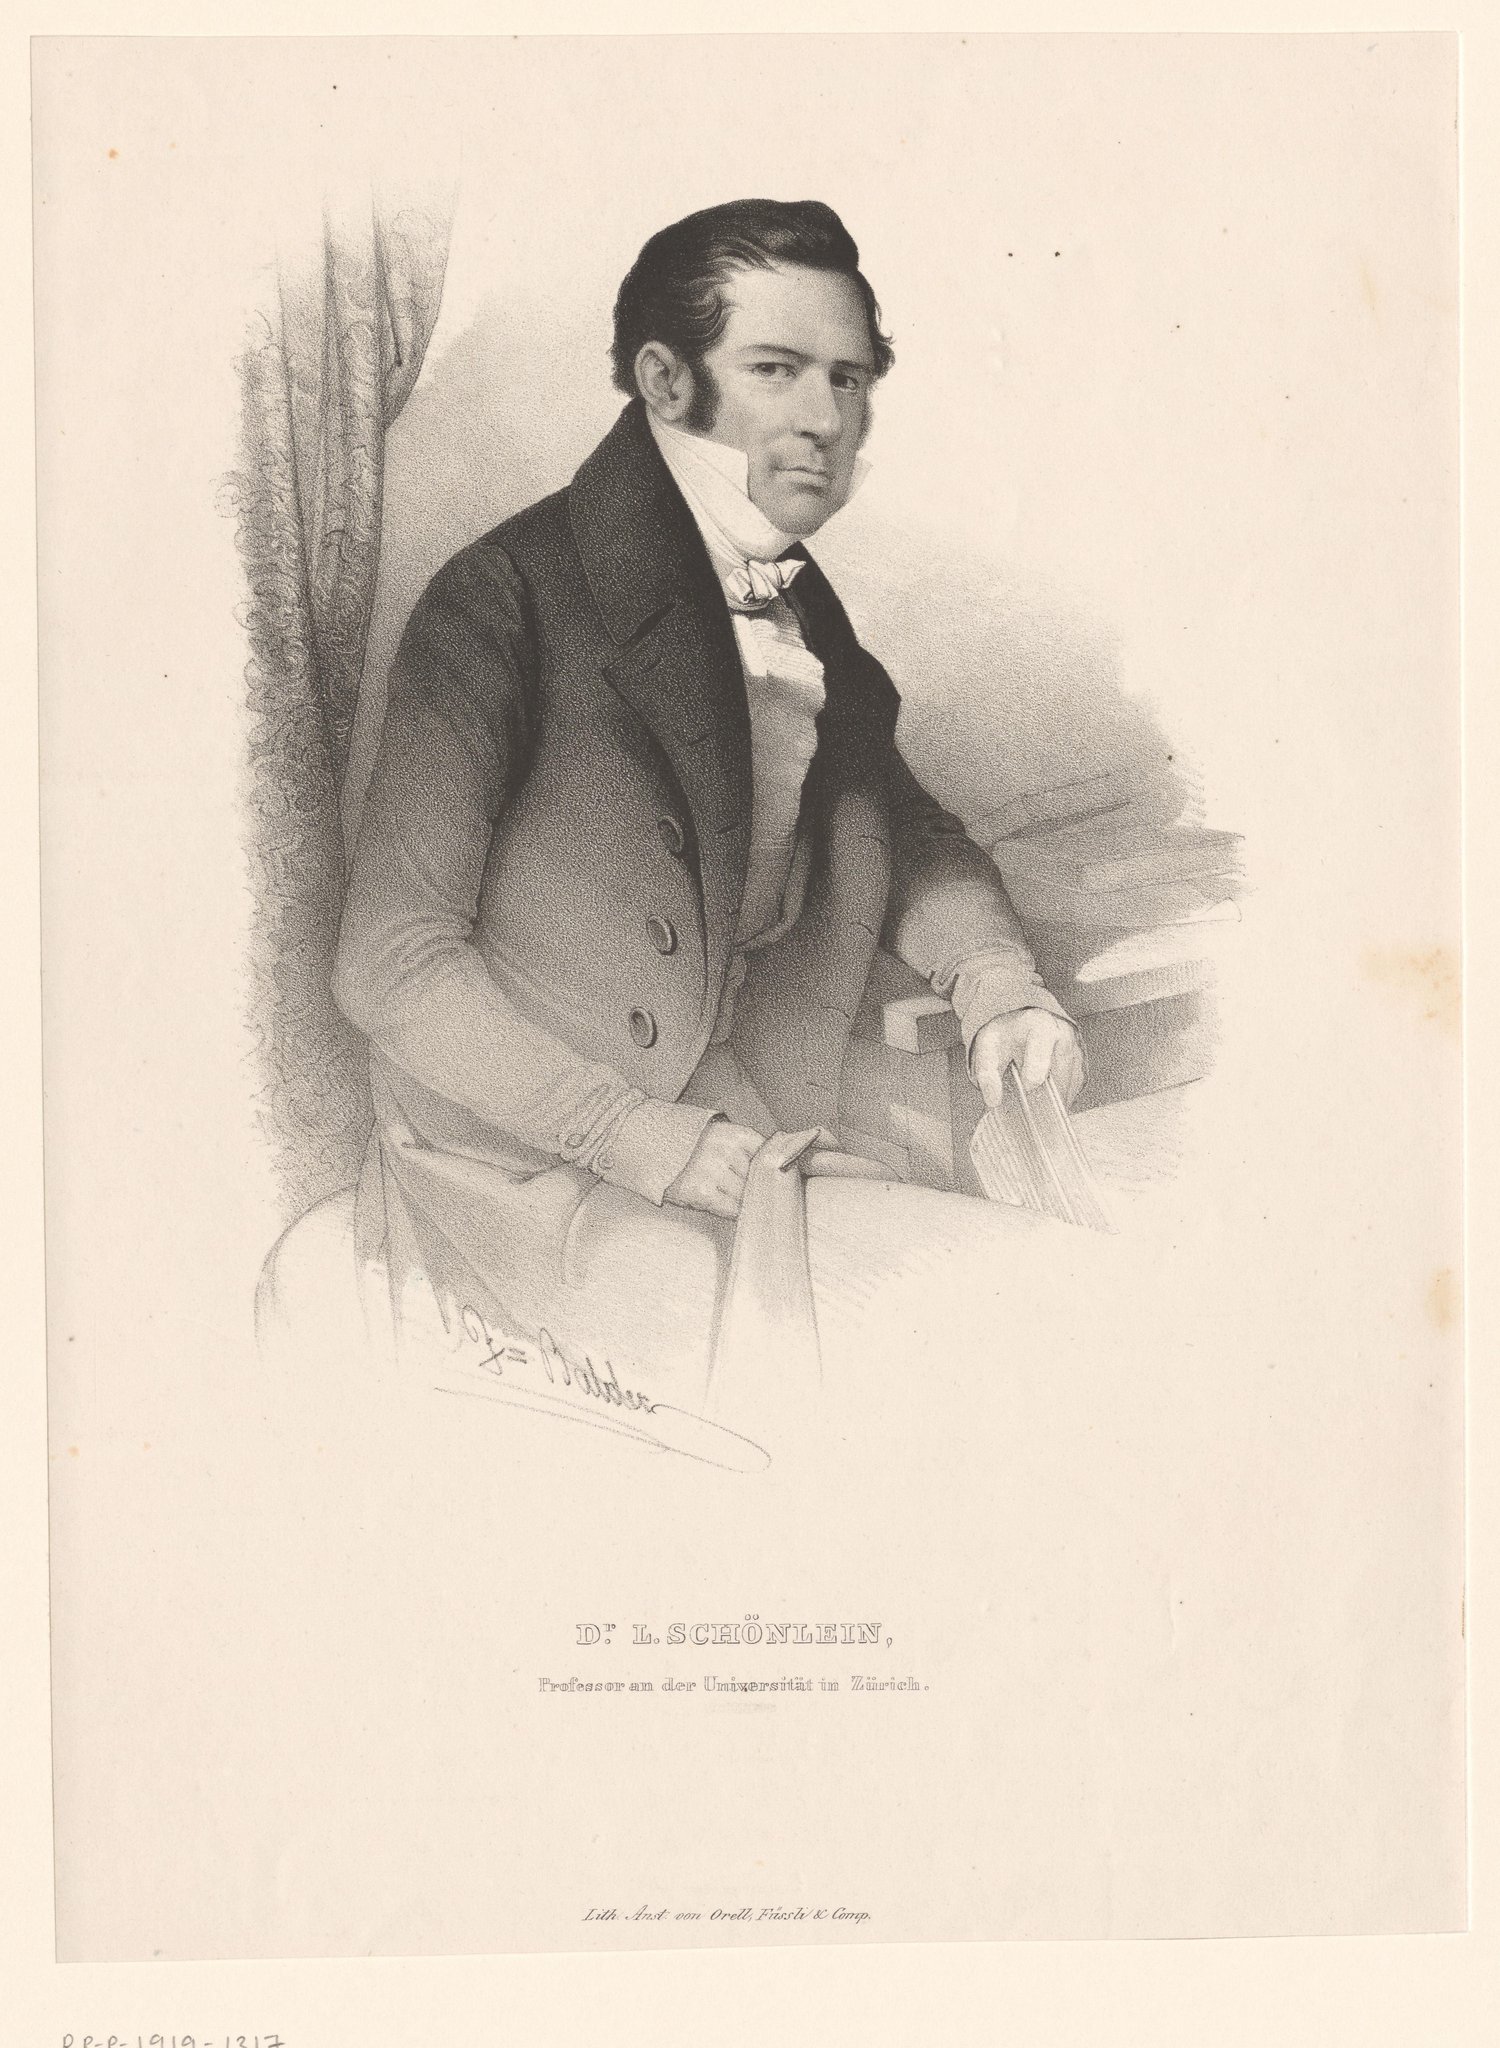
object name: print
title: Portret van Johann Lukas Schönlein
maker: georg balder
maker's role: print maker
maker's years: 1810-1882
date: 1820-1882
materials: paper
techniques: lithograph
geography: zurich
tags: historical persons, medicine, medical science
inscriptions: collector's mark: Lugt 2228